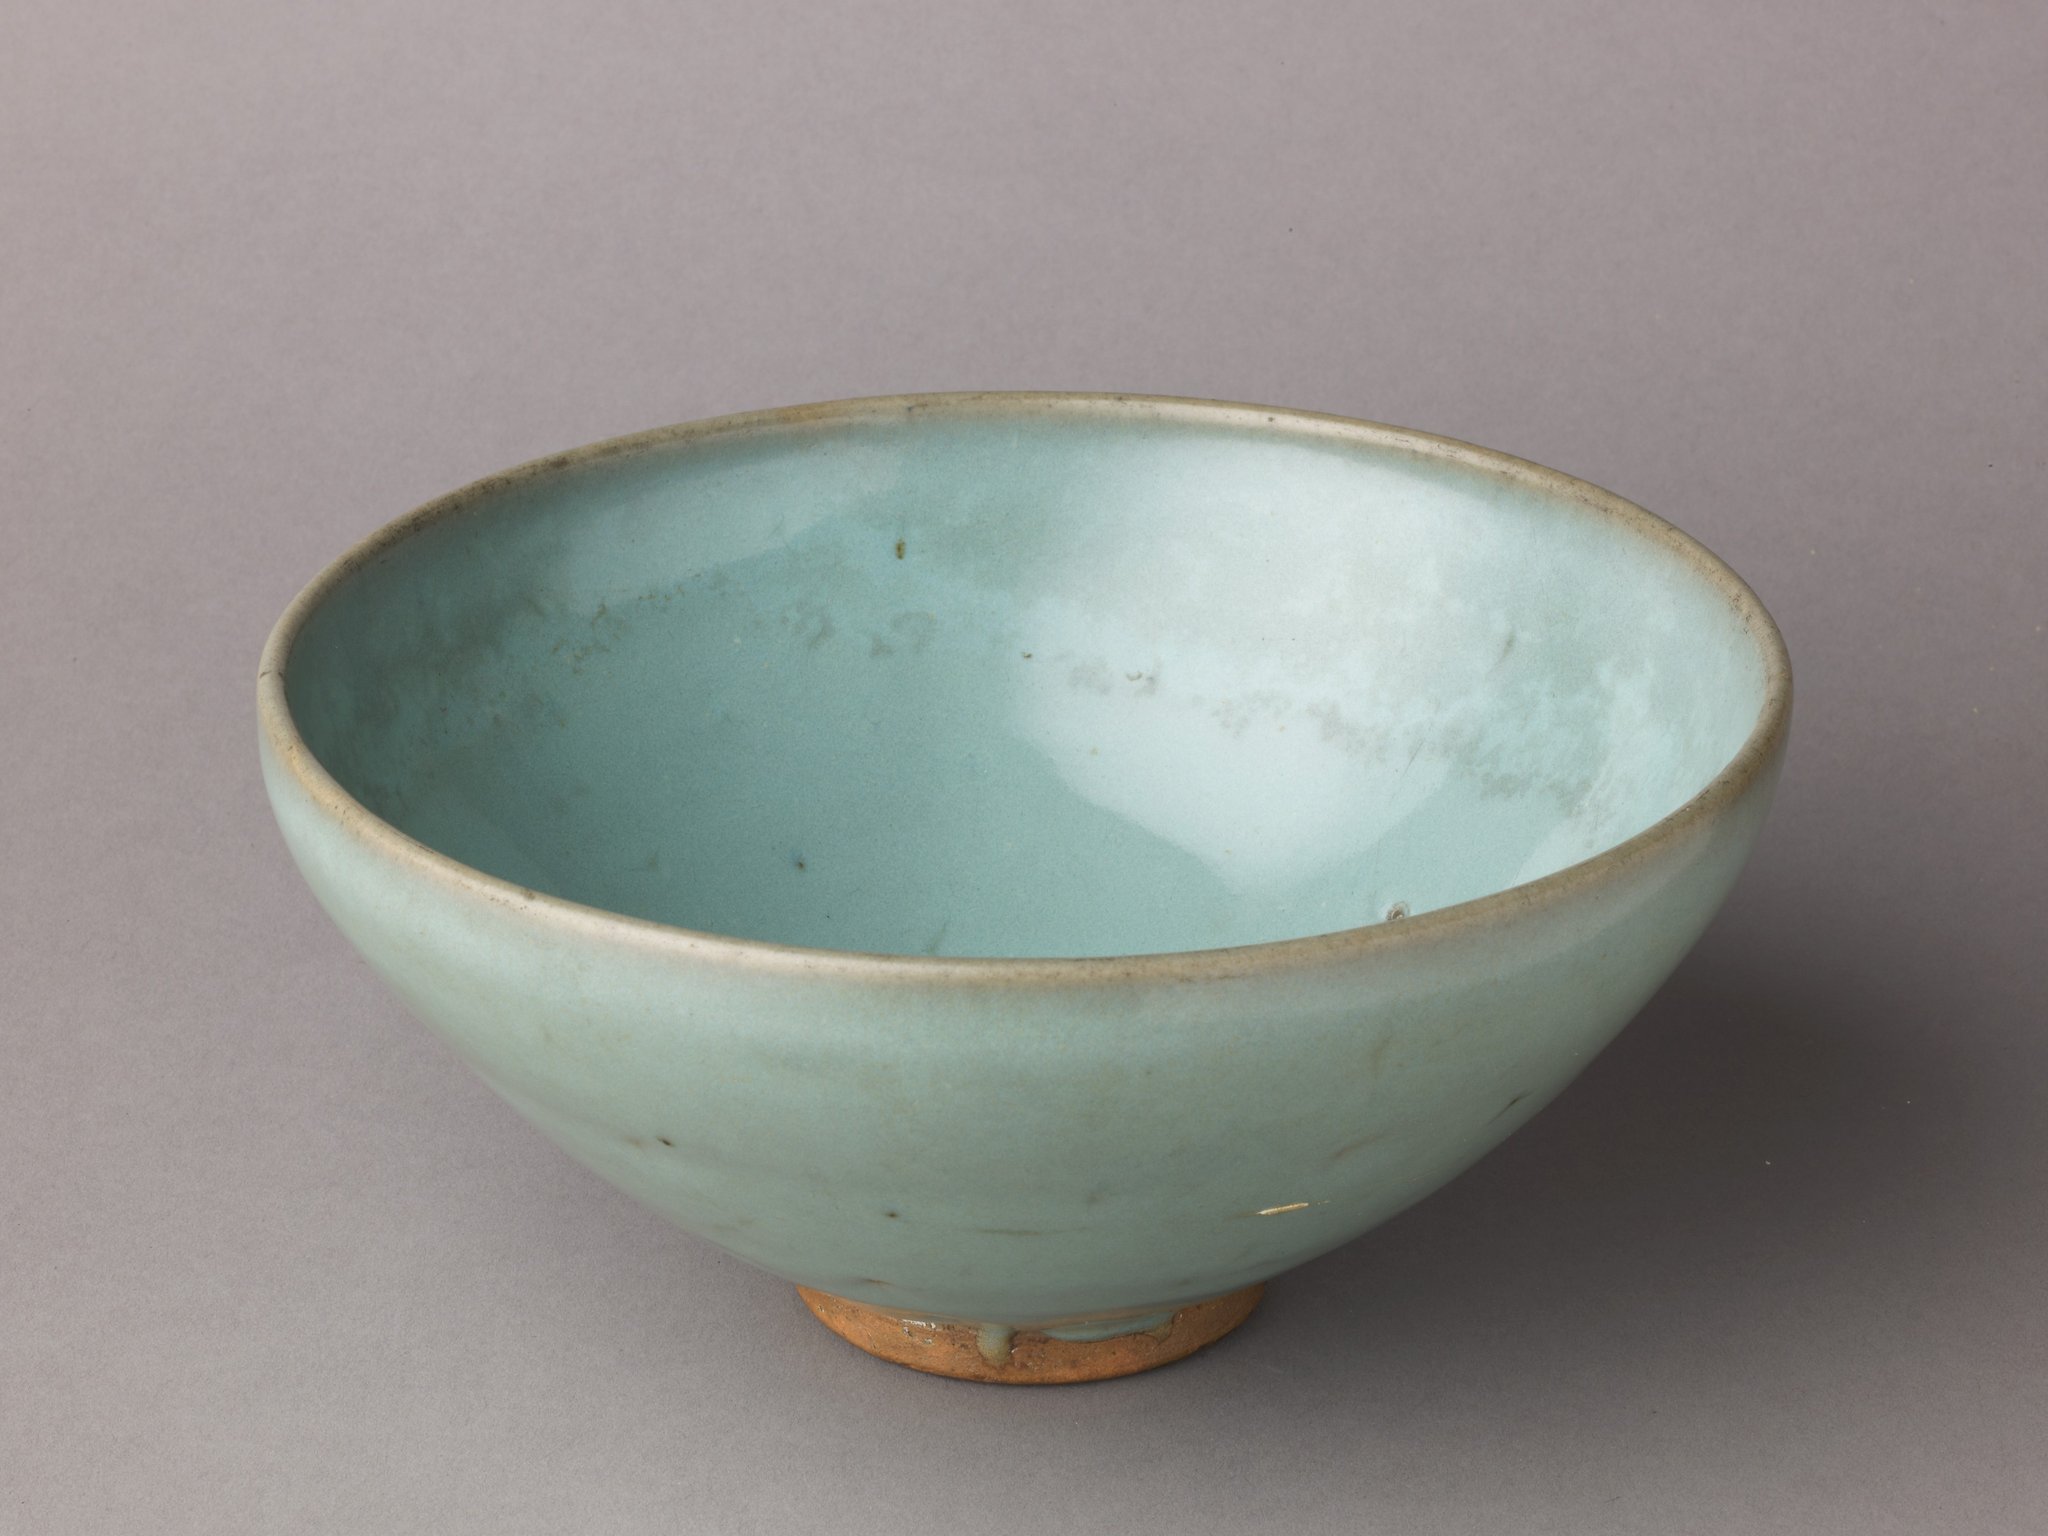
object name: bowl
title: Deep bowl, Jun ware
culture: chinese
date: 1001-1200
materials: glaze, stoneware